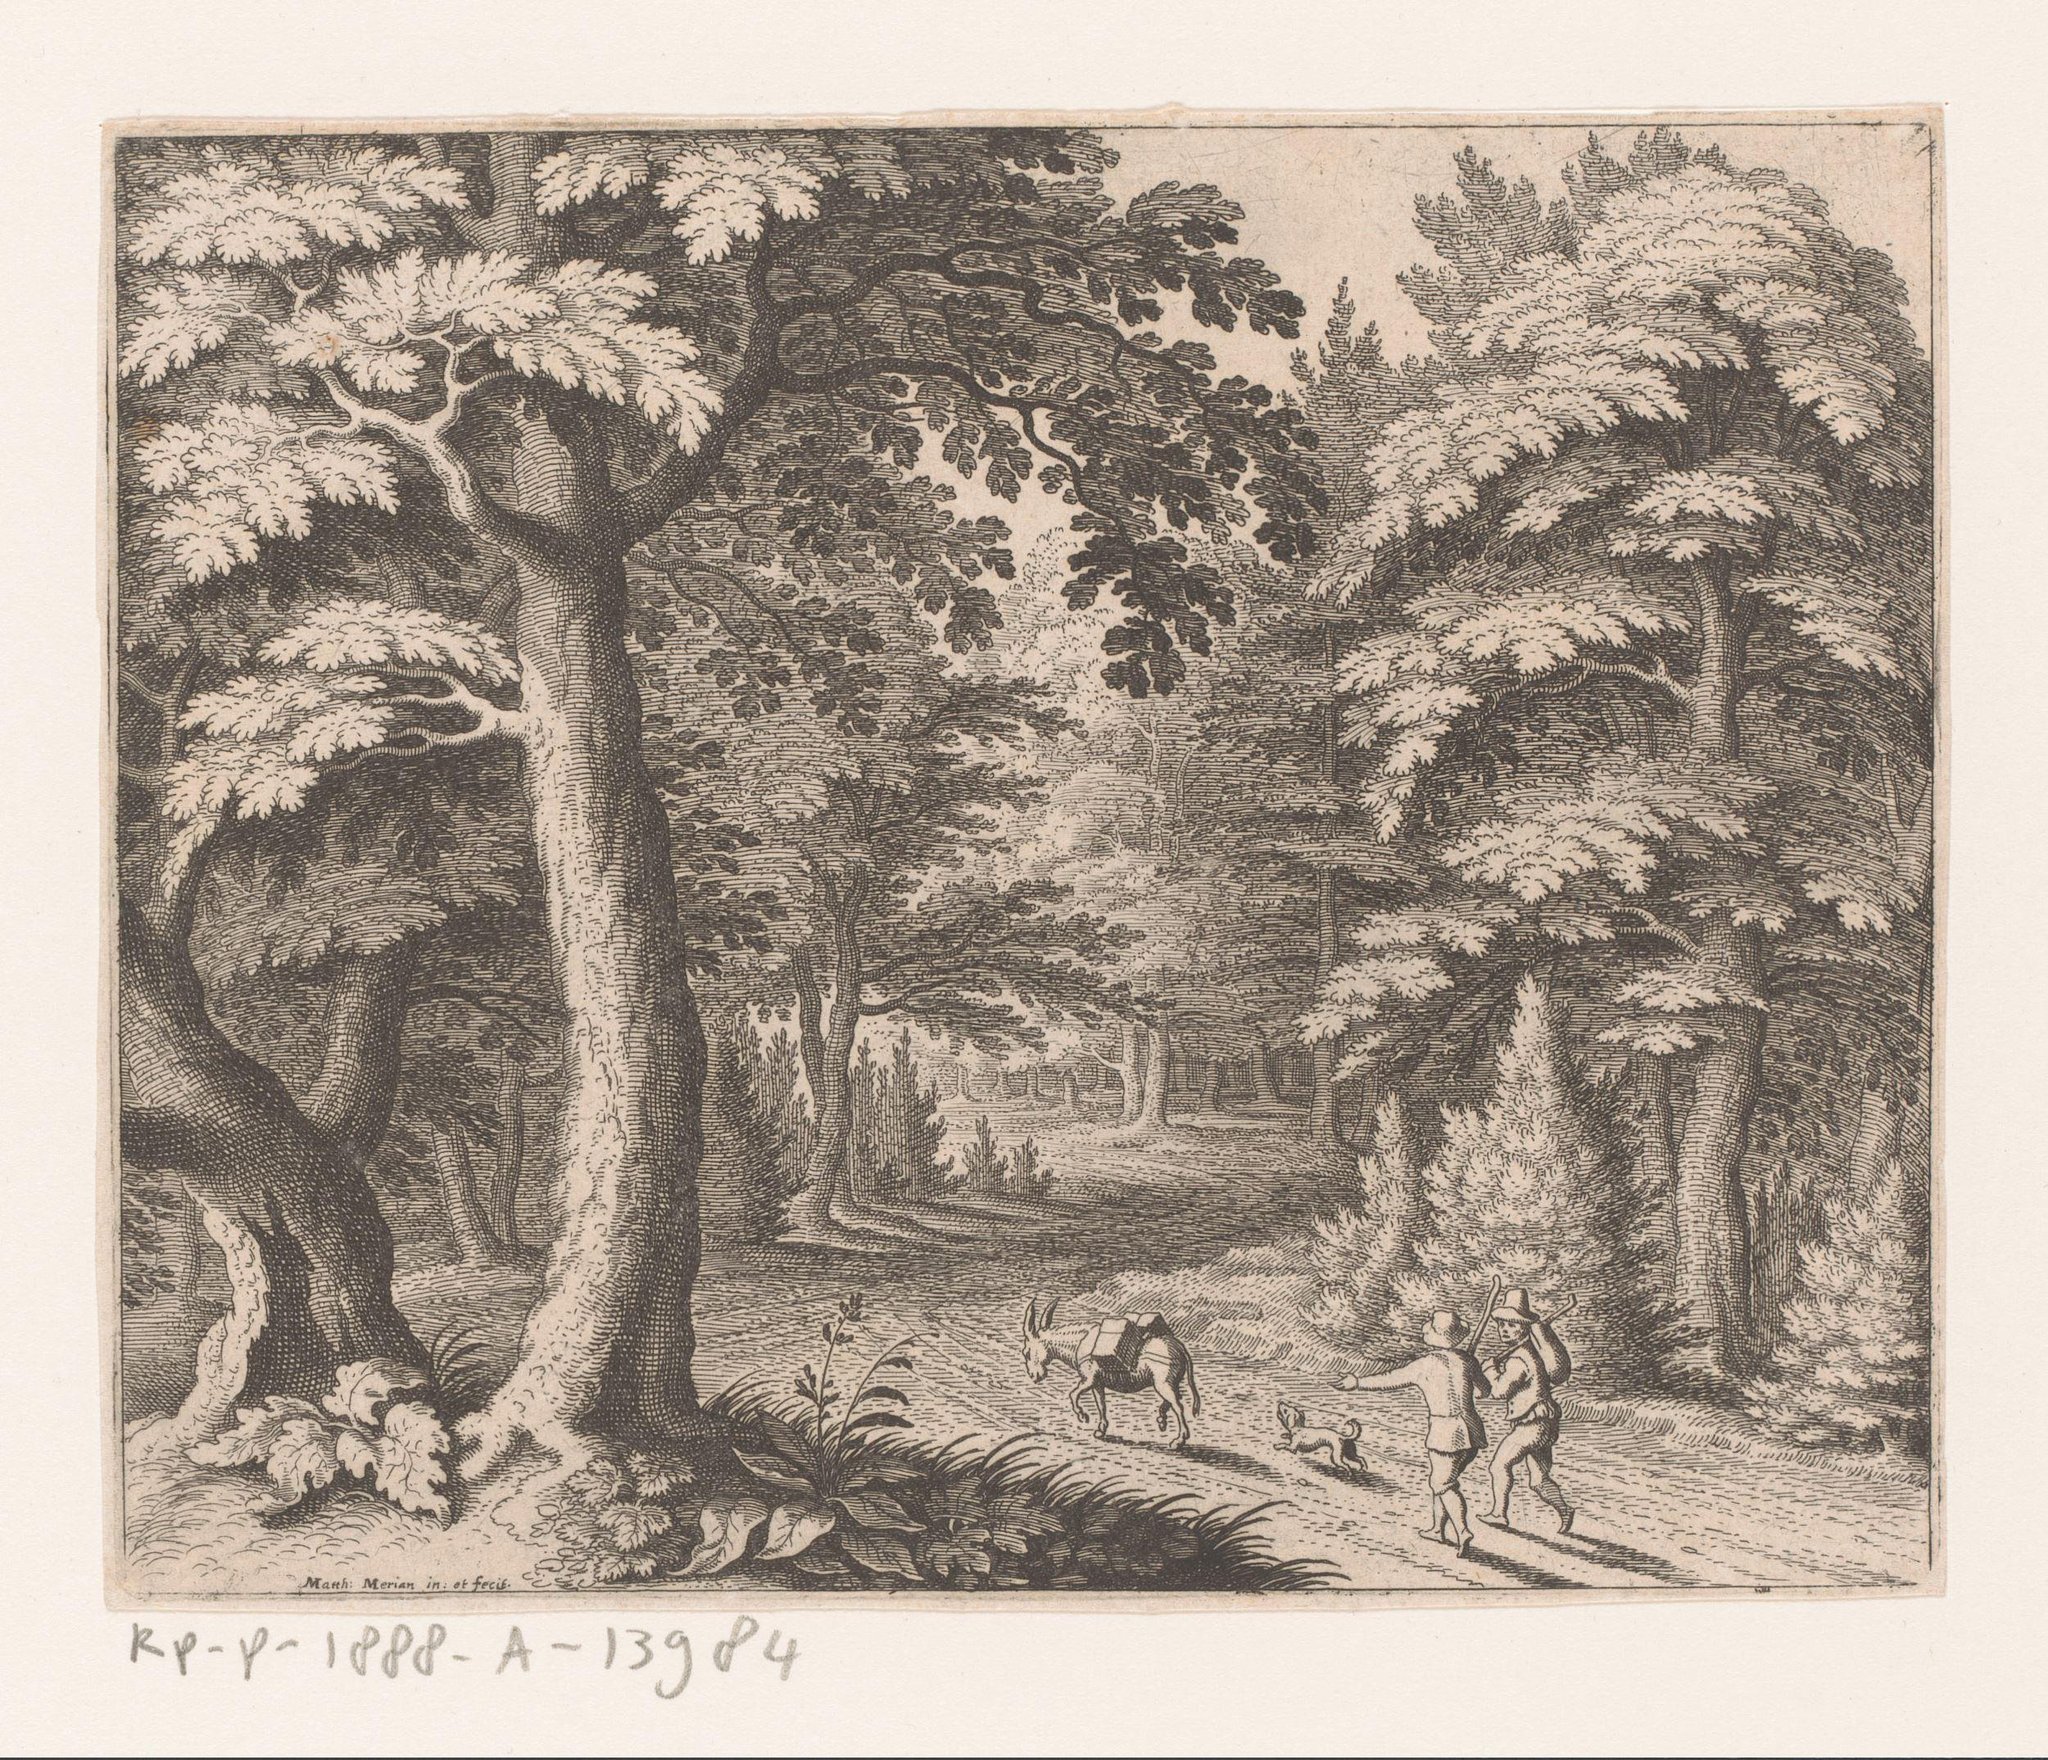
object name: print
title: Zeventien landschappen in de omgeving van Bazel in Zwitserland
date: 1625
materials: paper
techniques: etching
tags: forest path or lane, 'en route', traveller under way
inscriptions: collector's mark: Lugt 2228